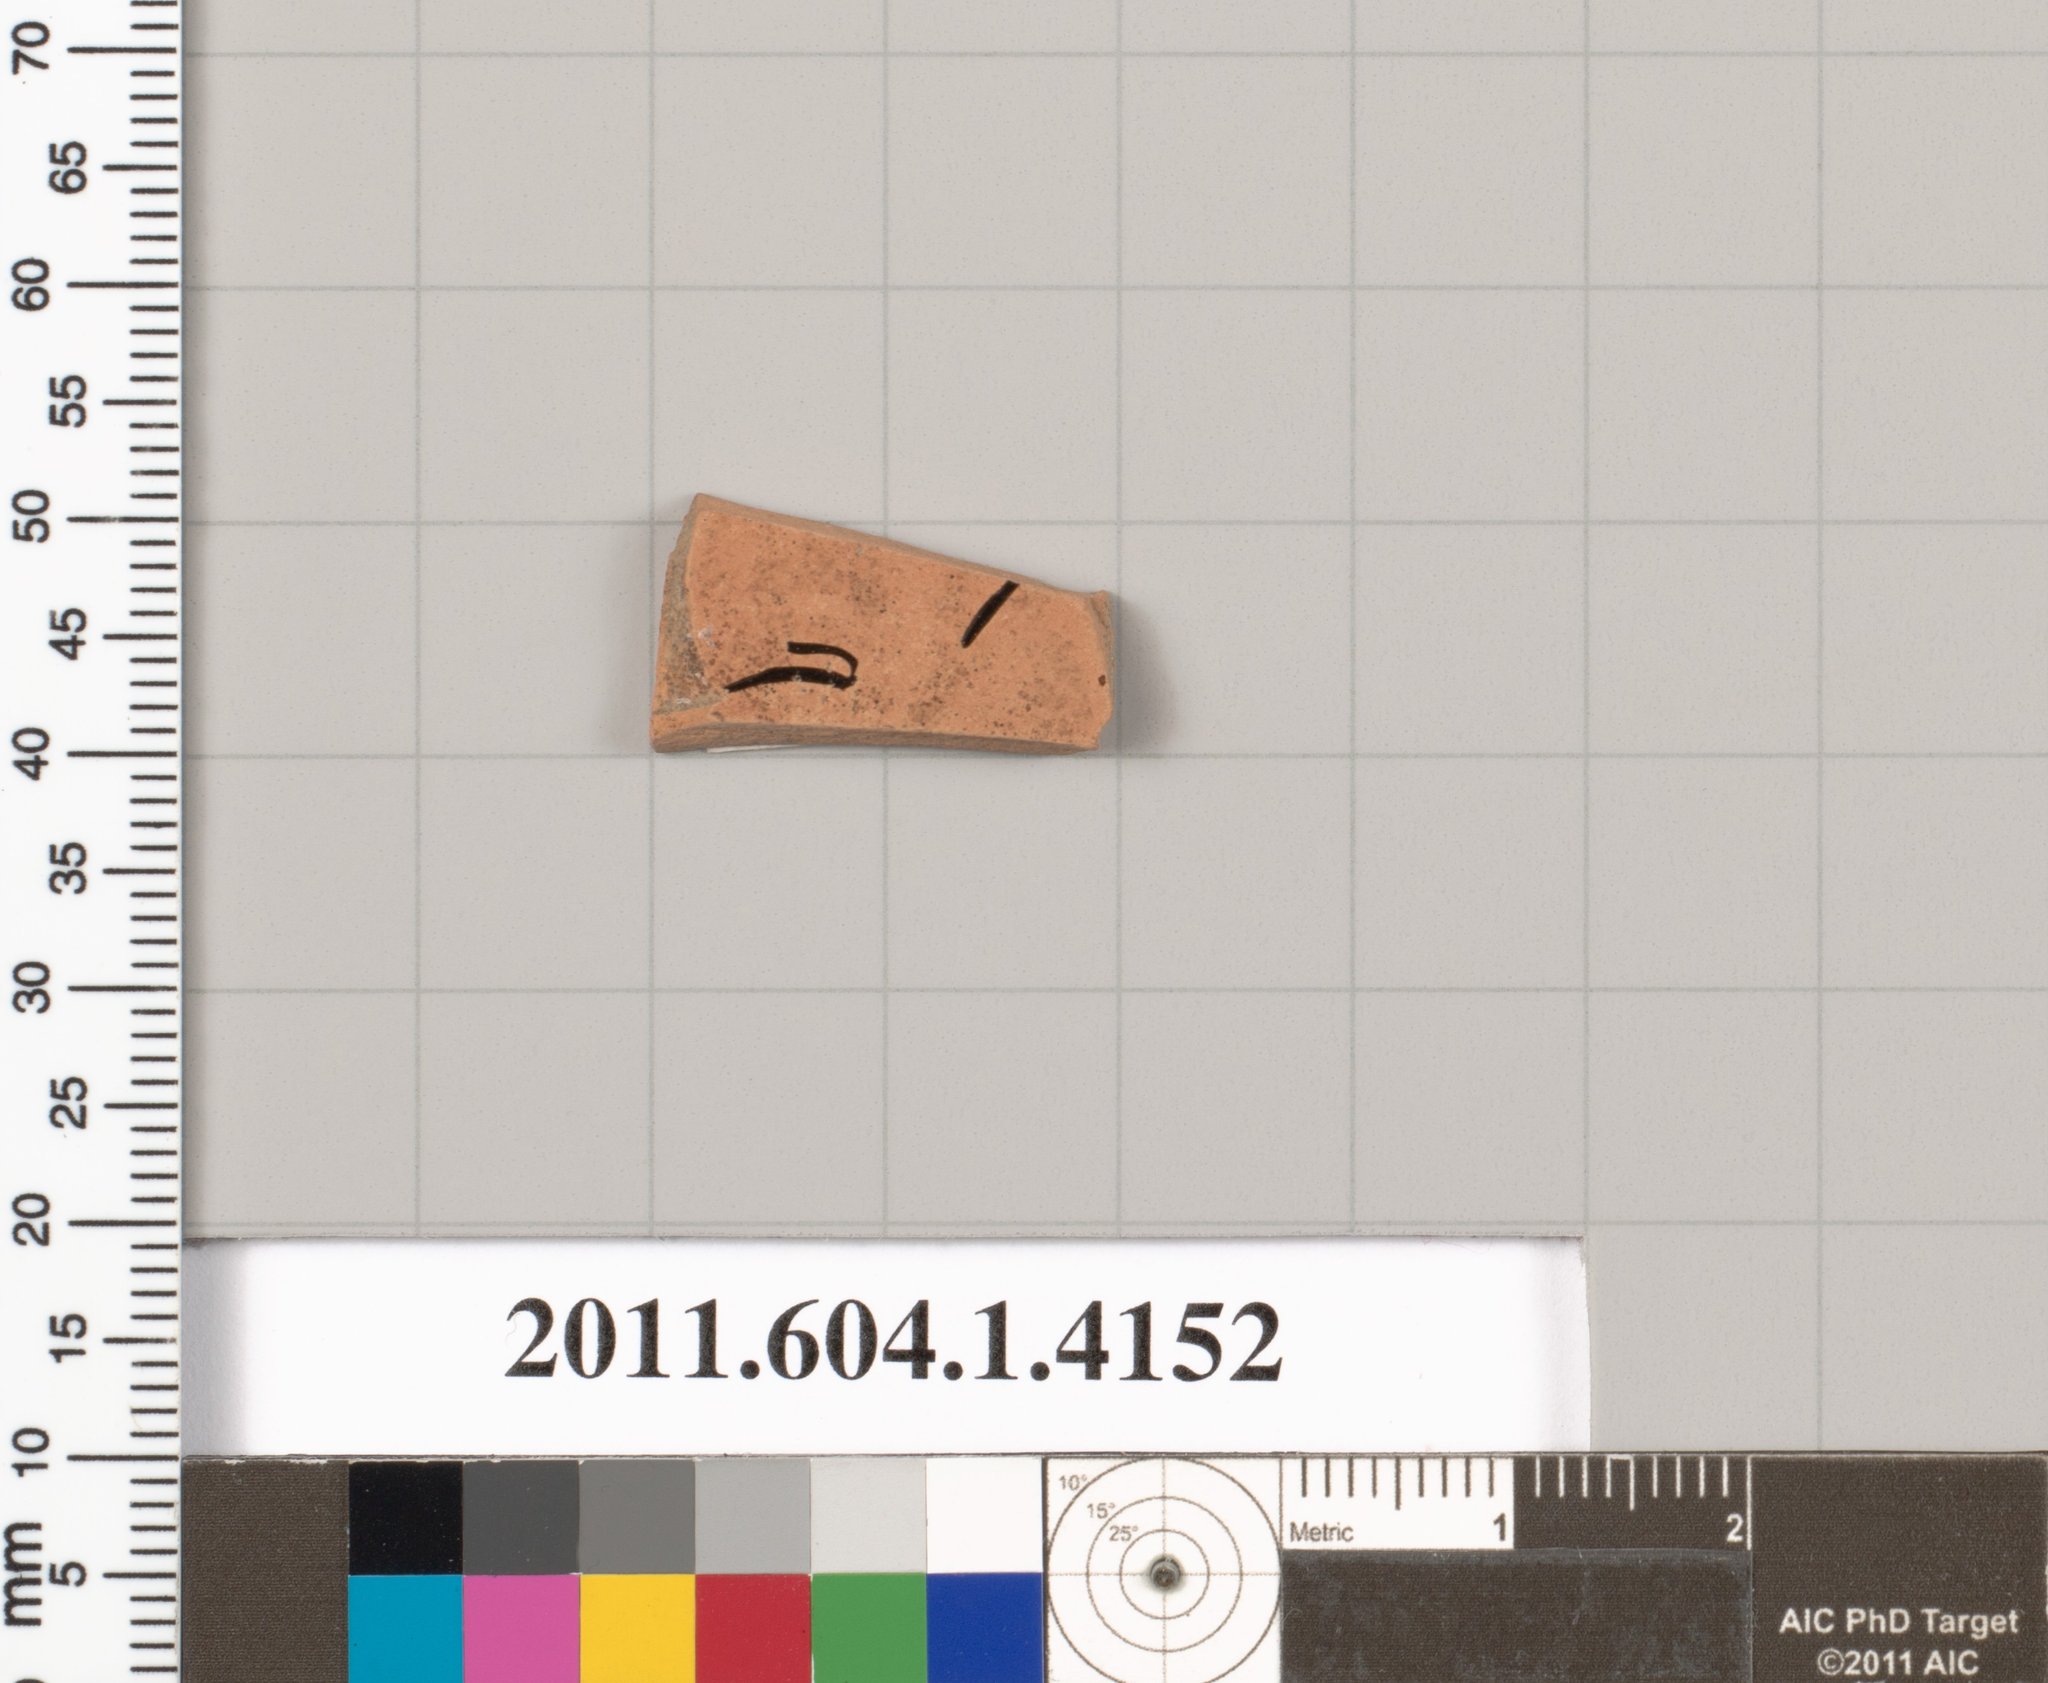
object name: kylix fragment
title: Terracotta fragment of a kylix (drinking cup)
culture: greek, attic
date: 500-451 BCE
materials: terracotta